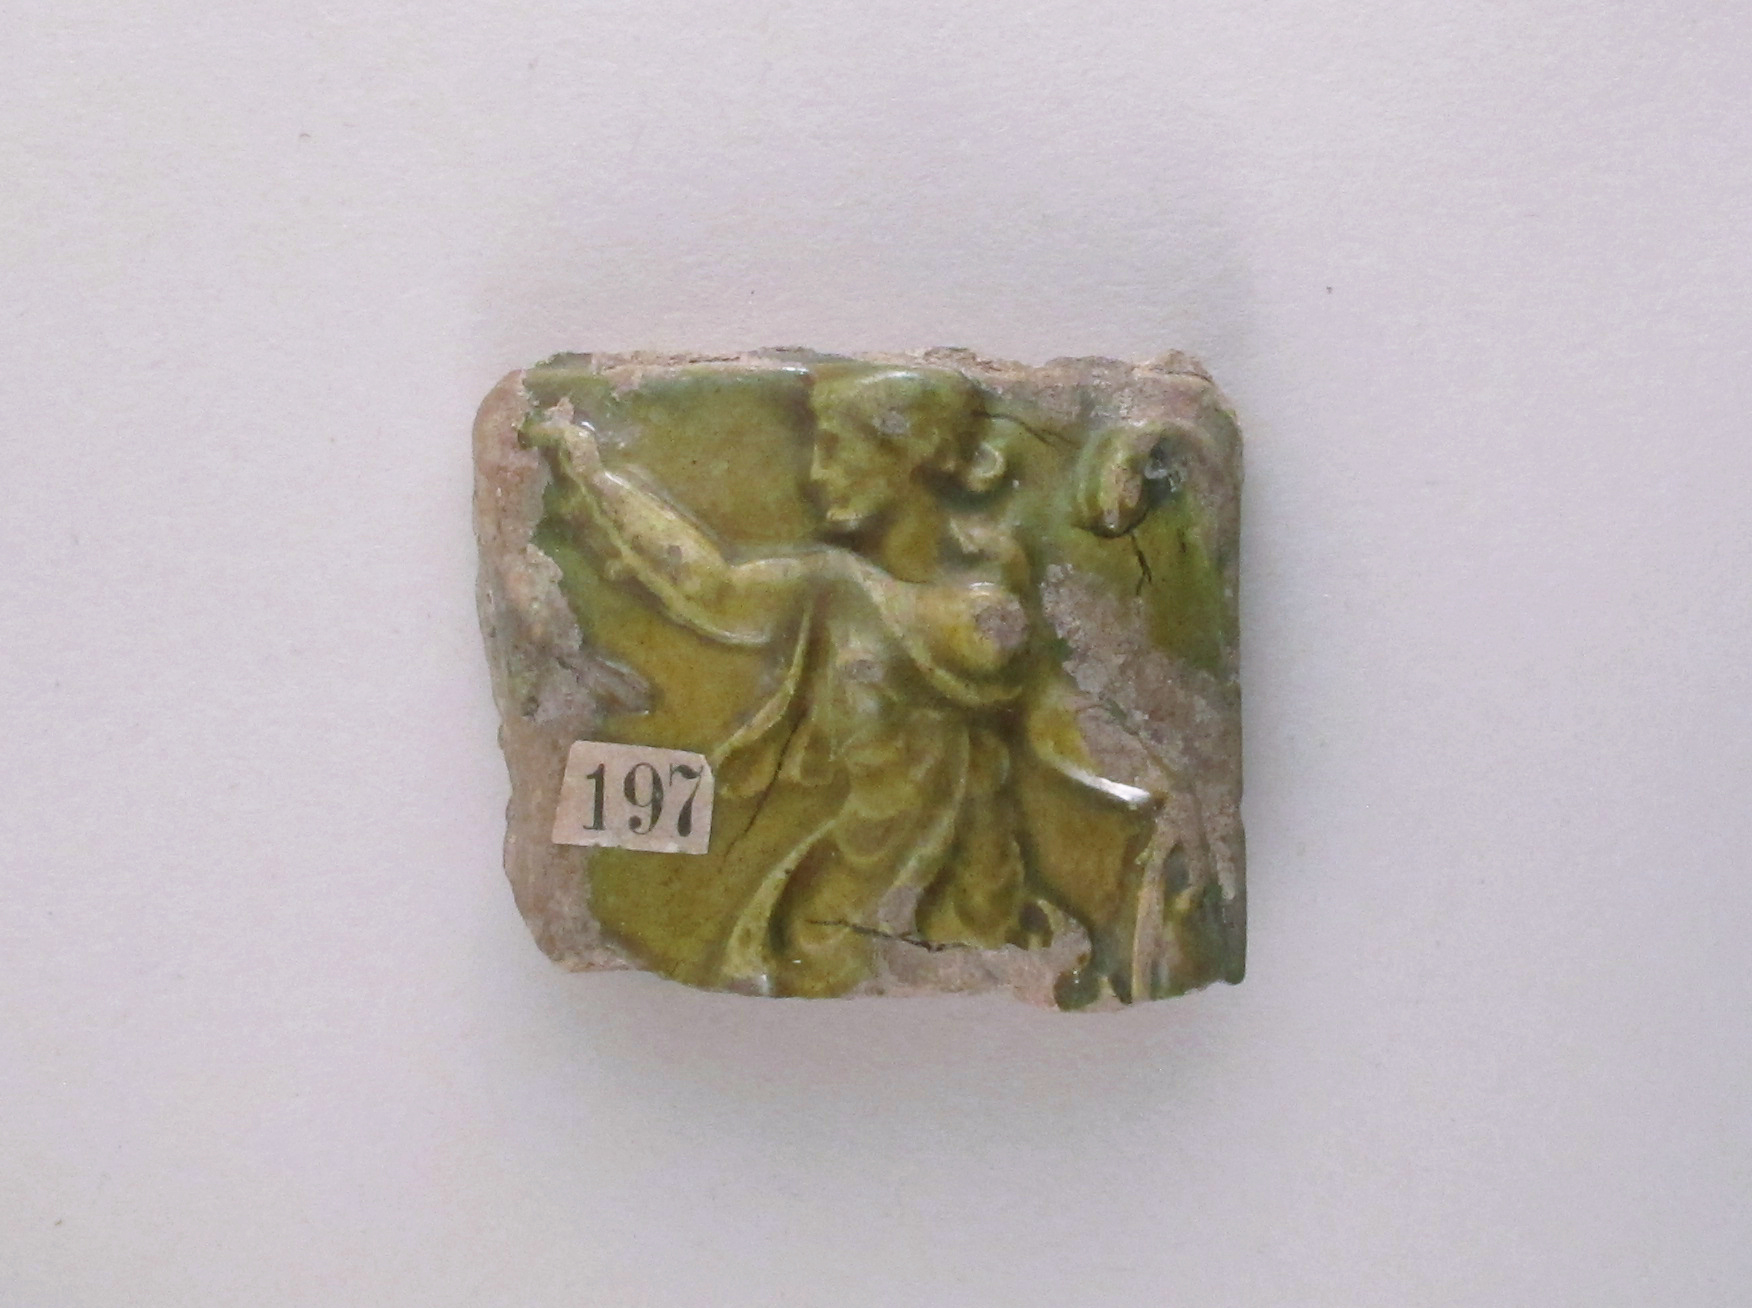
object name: vase fragment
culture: roman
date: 670 BCE-330 CE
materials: terracotta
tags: women